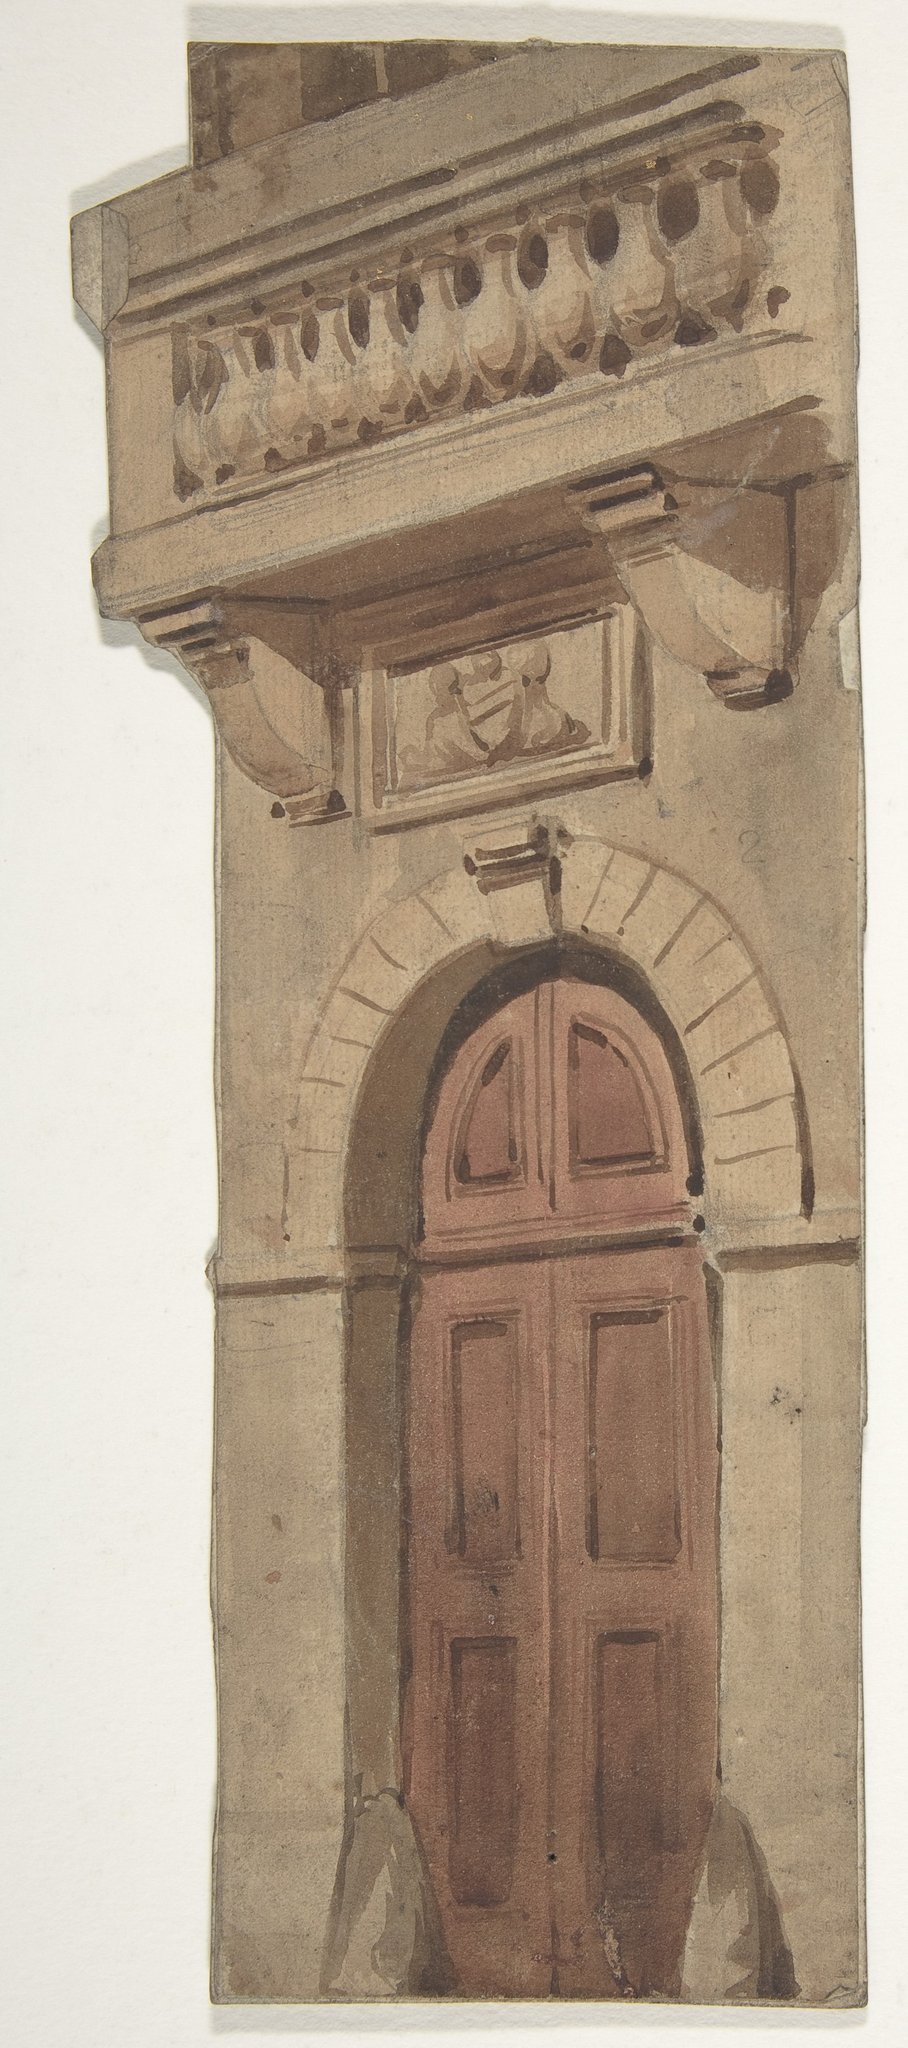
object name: drawing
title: Design for a Stage Set at the Opéra, Paris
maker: eugène cicéri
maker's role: artist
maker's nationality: french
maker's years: 1813-1890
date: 1830-1890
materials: graphite, watercolor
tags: buildings,stage design